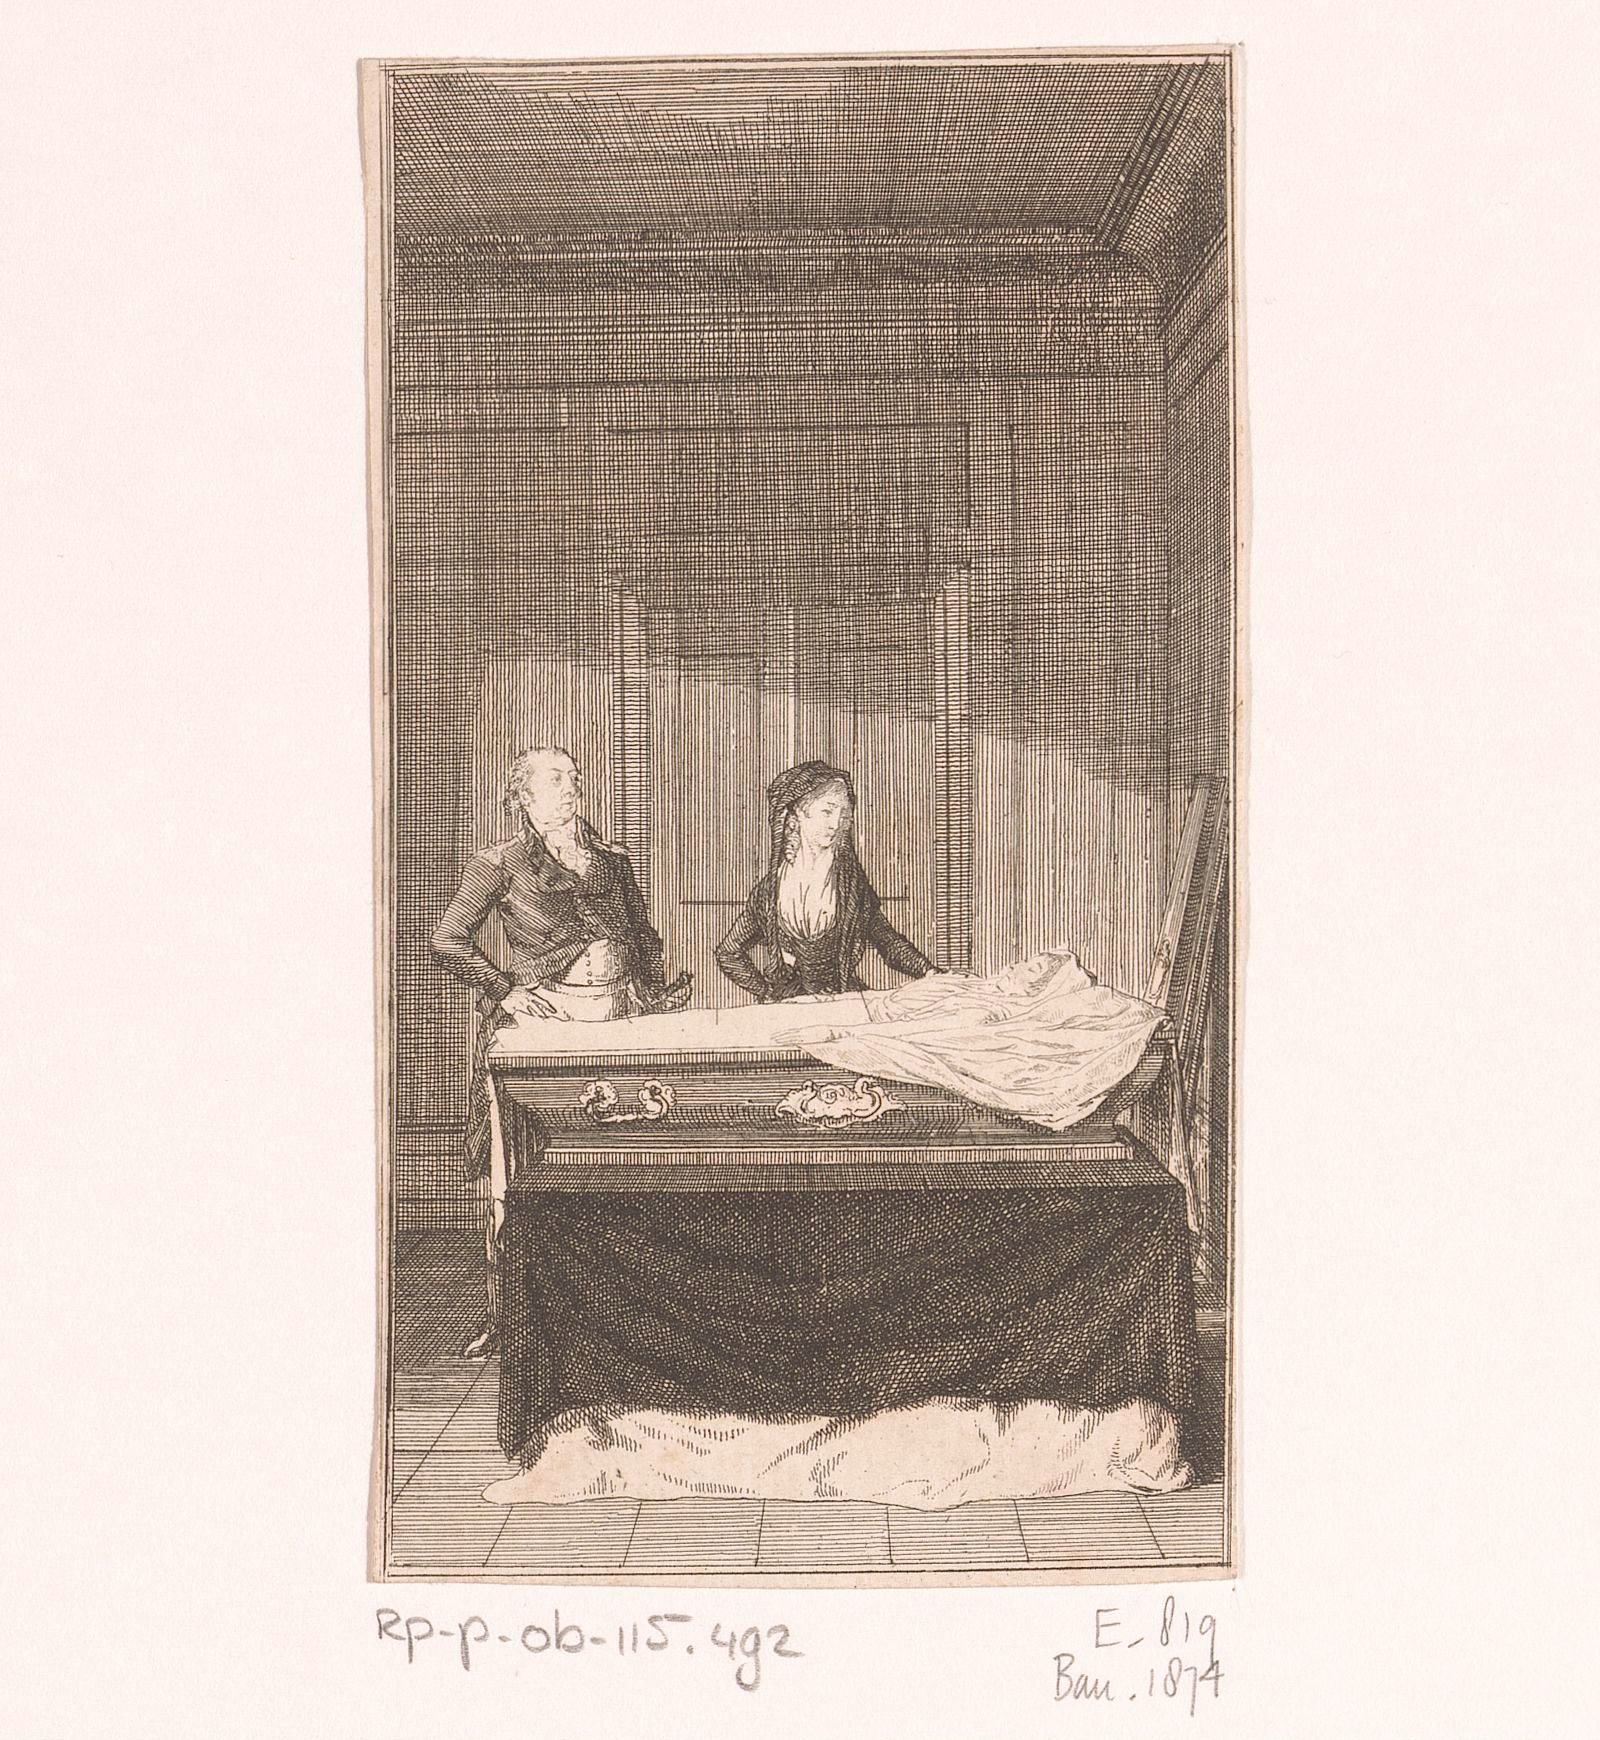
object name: print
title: Anne Howe en Oberst Morden rouwen bij het lichaam van Clarissa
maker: daniel nikolaus chodowiecki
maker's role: draughtsman, print maker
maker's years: 1726-1801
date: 1796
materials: paper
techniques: etching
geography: berlin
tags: literature, coffin, the corpse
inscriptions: collector's mark: Lugt 2228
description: Latere staat gebruikt voor: Richardson, Samuel. Clarissens Schicksale dargestellt in vier und zwanzig Kupferblättern von Daniel Chodowiecki. mit Erläuterungen des Deutschen Uebersetzers Dr. L. Th. Kosegarten. Leipzig: Heinrich Gräff, 1796.